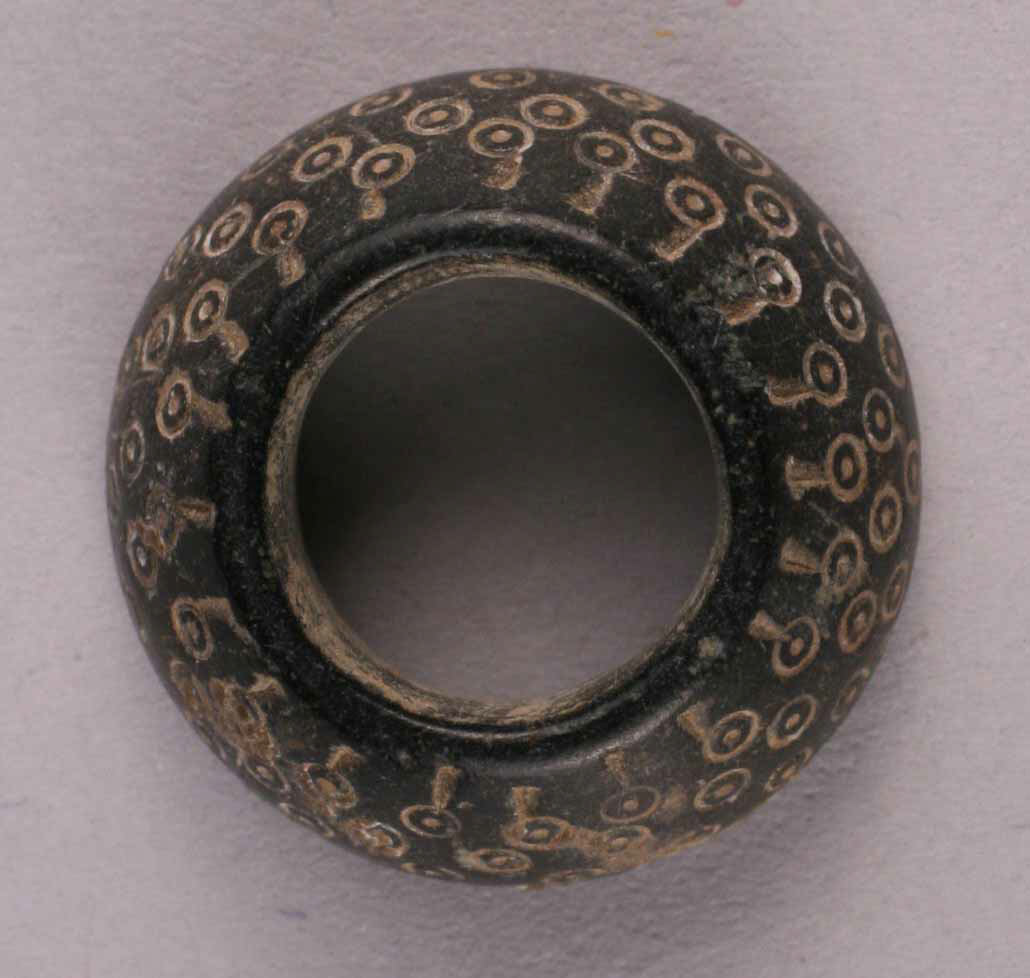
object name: button or bead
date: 701-1000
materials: stone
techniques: carving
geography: iran